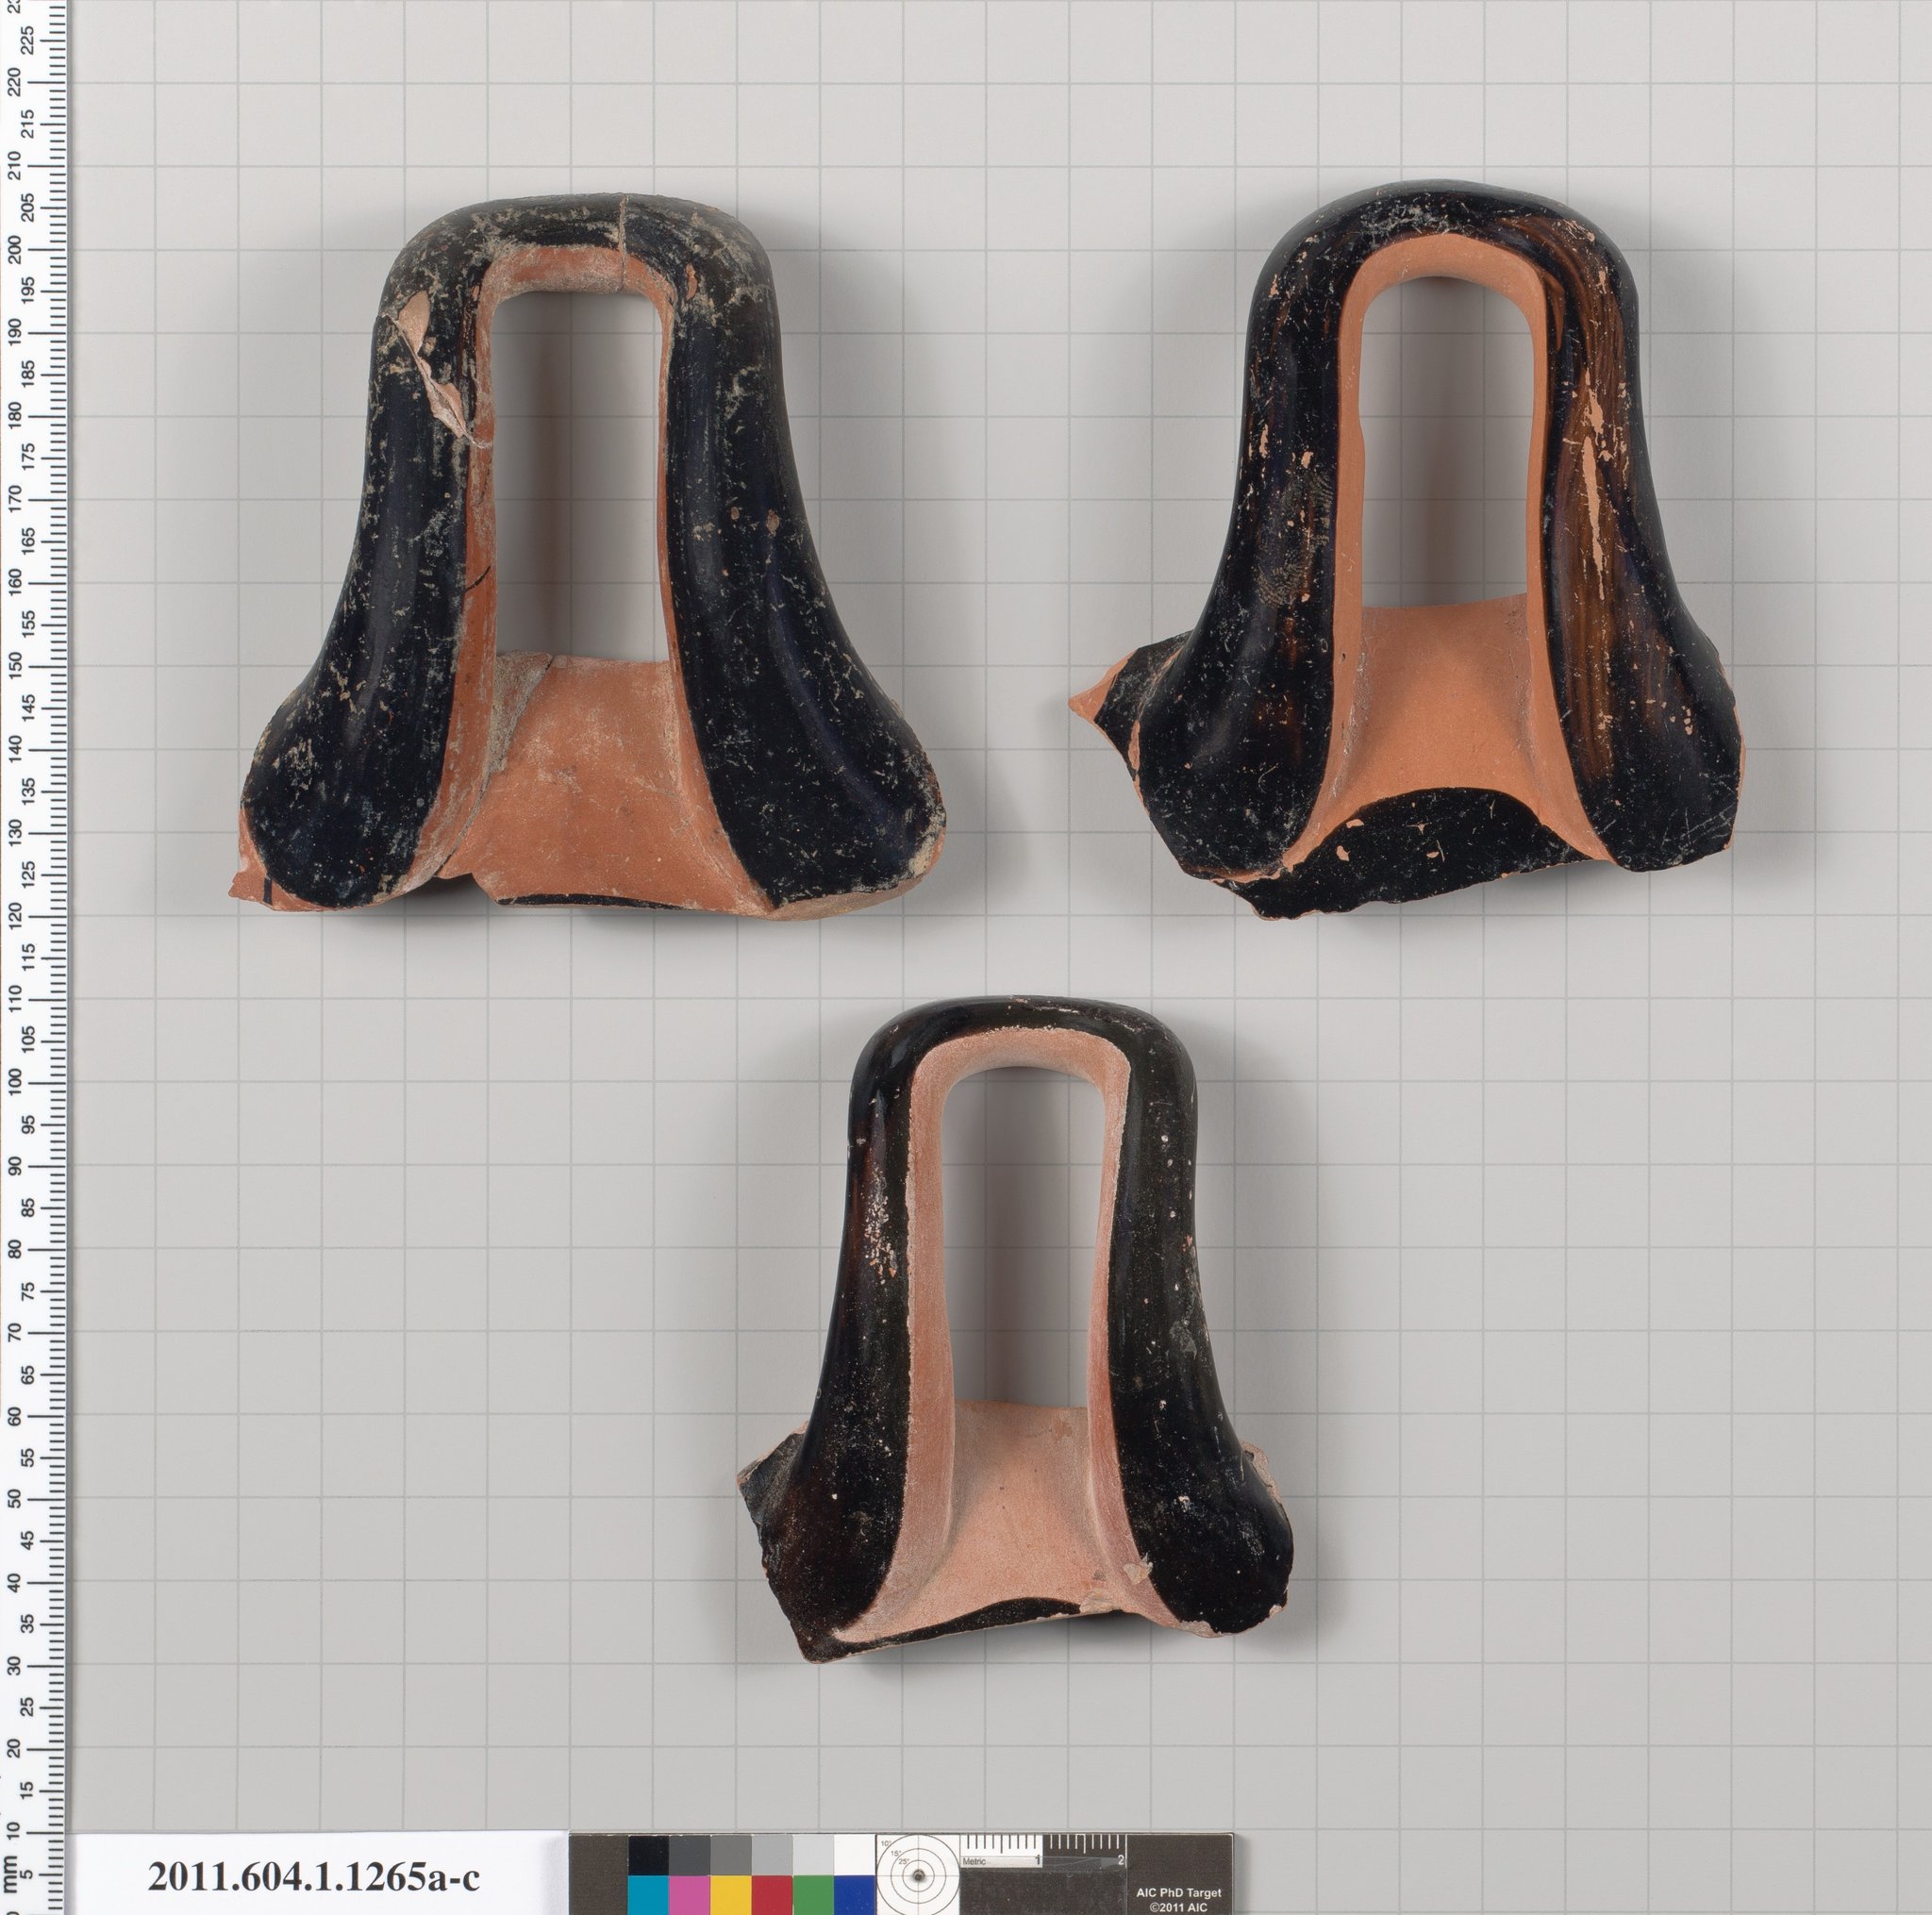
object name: kylix fragment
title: Terracotta fragments of kylikes (drinking cups)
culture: greek, attic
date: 500-401 BCE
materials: terracotta